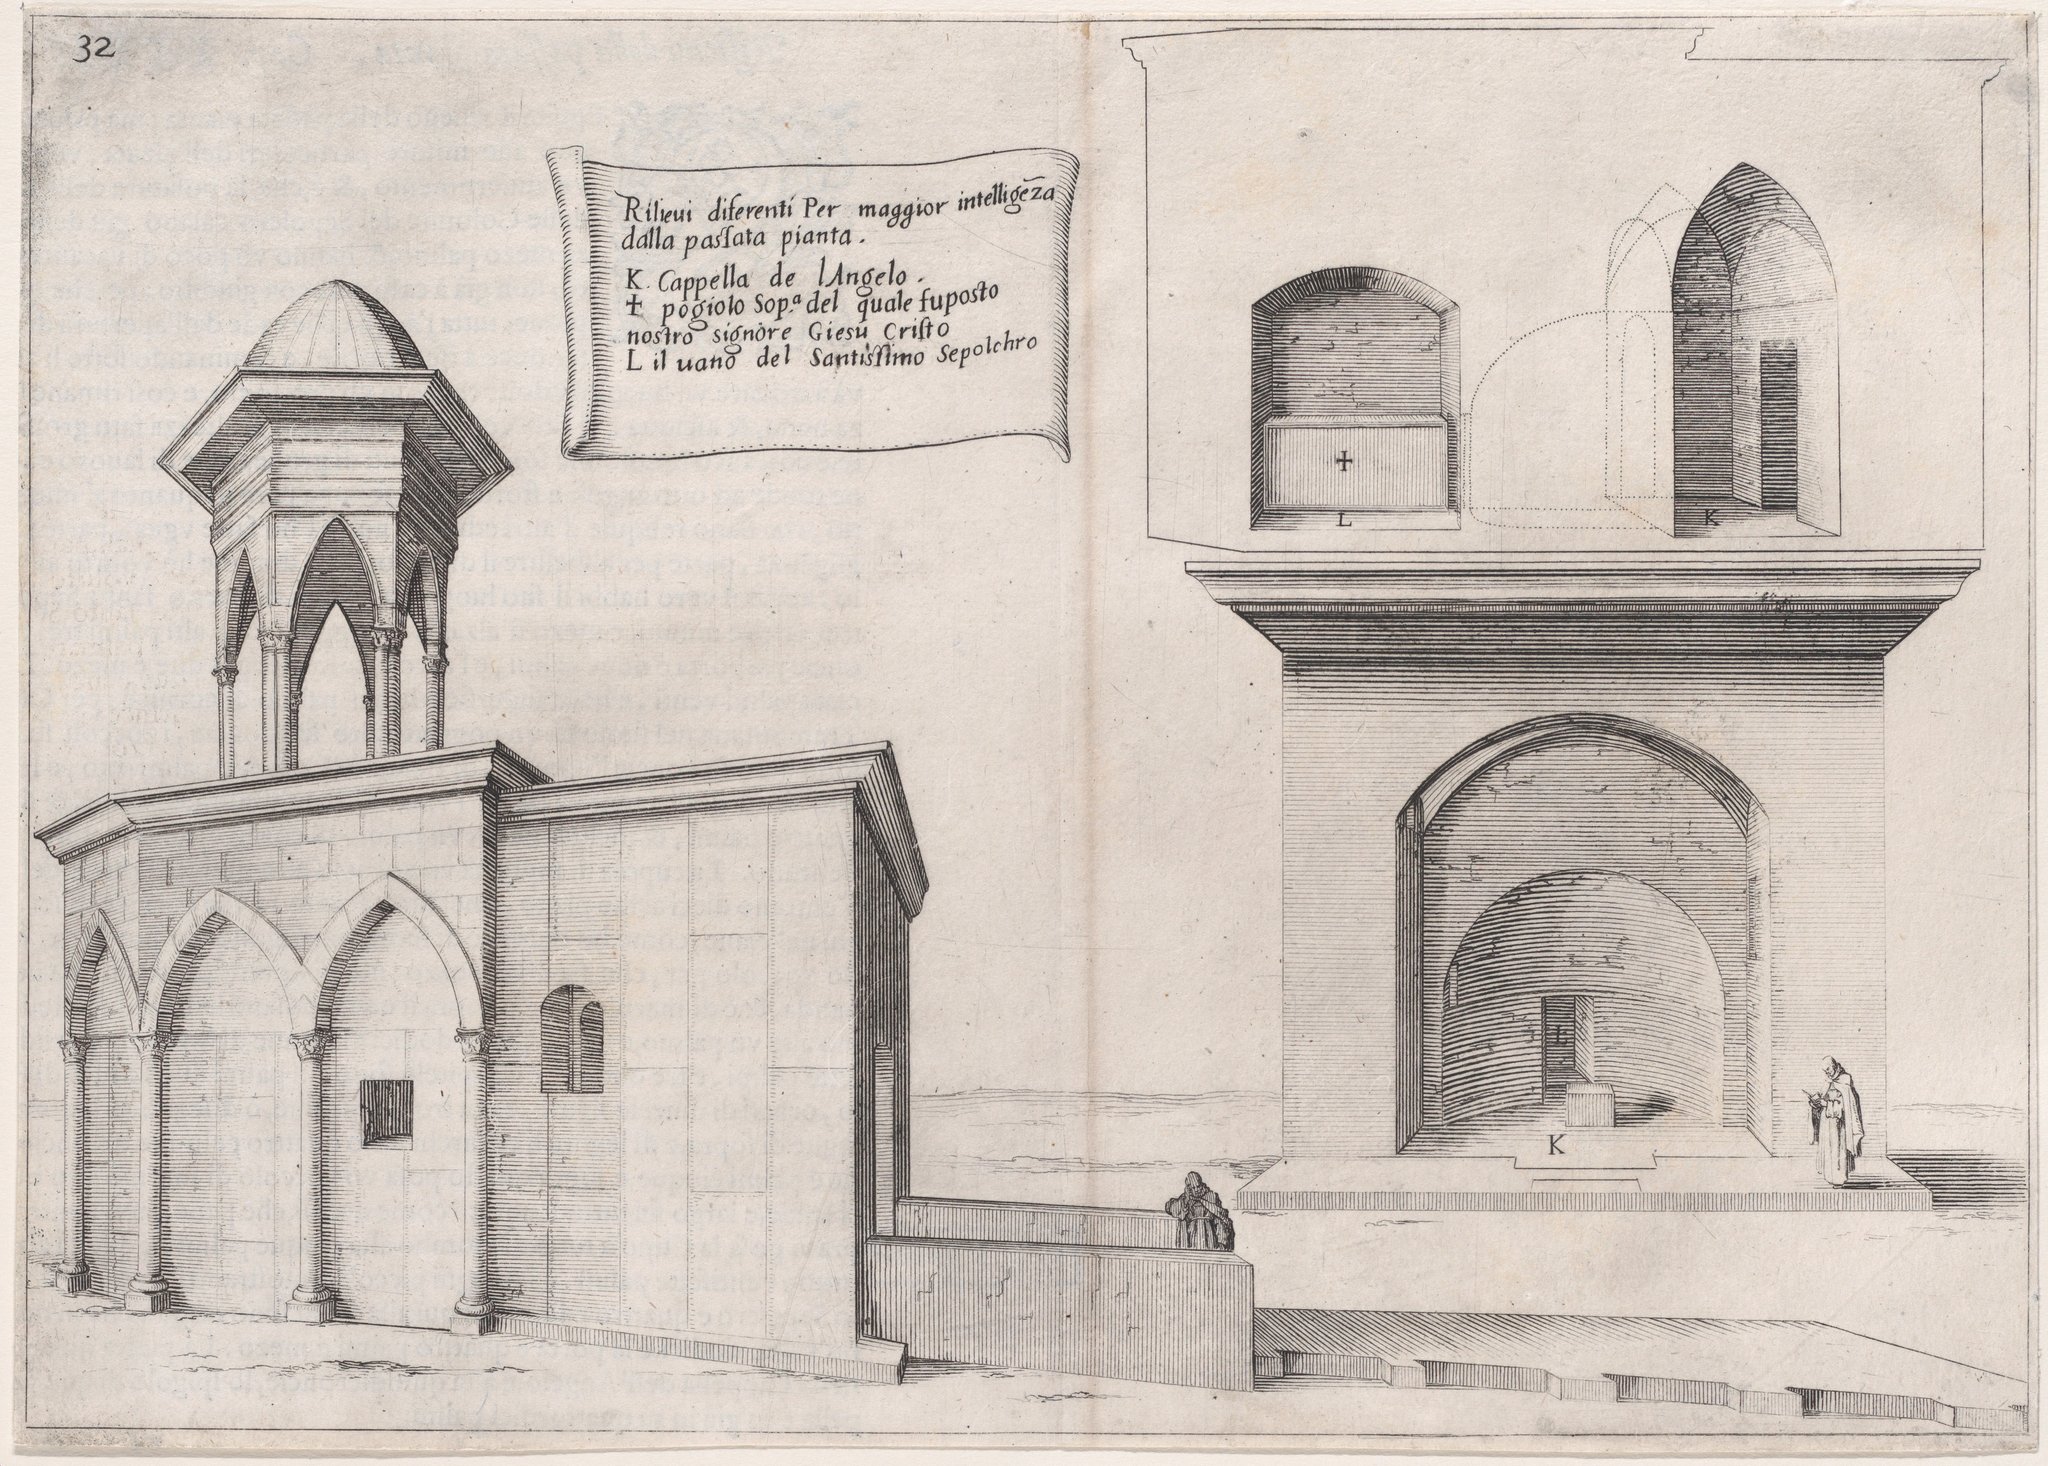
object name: print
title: Plate 25, from "Trattato delle Piante & Immagini de Sacri Edifizi di Terra Santa" (Treatise of the Plans & Images of the Sacred Buildings of the Holy Land)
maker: jacques callot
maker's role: artist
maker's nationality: french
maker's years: 1592-1635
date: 1620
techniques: engraving, etching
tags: architecture,buildings